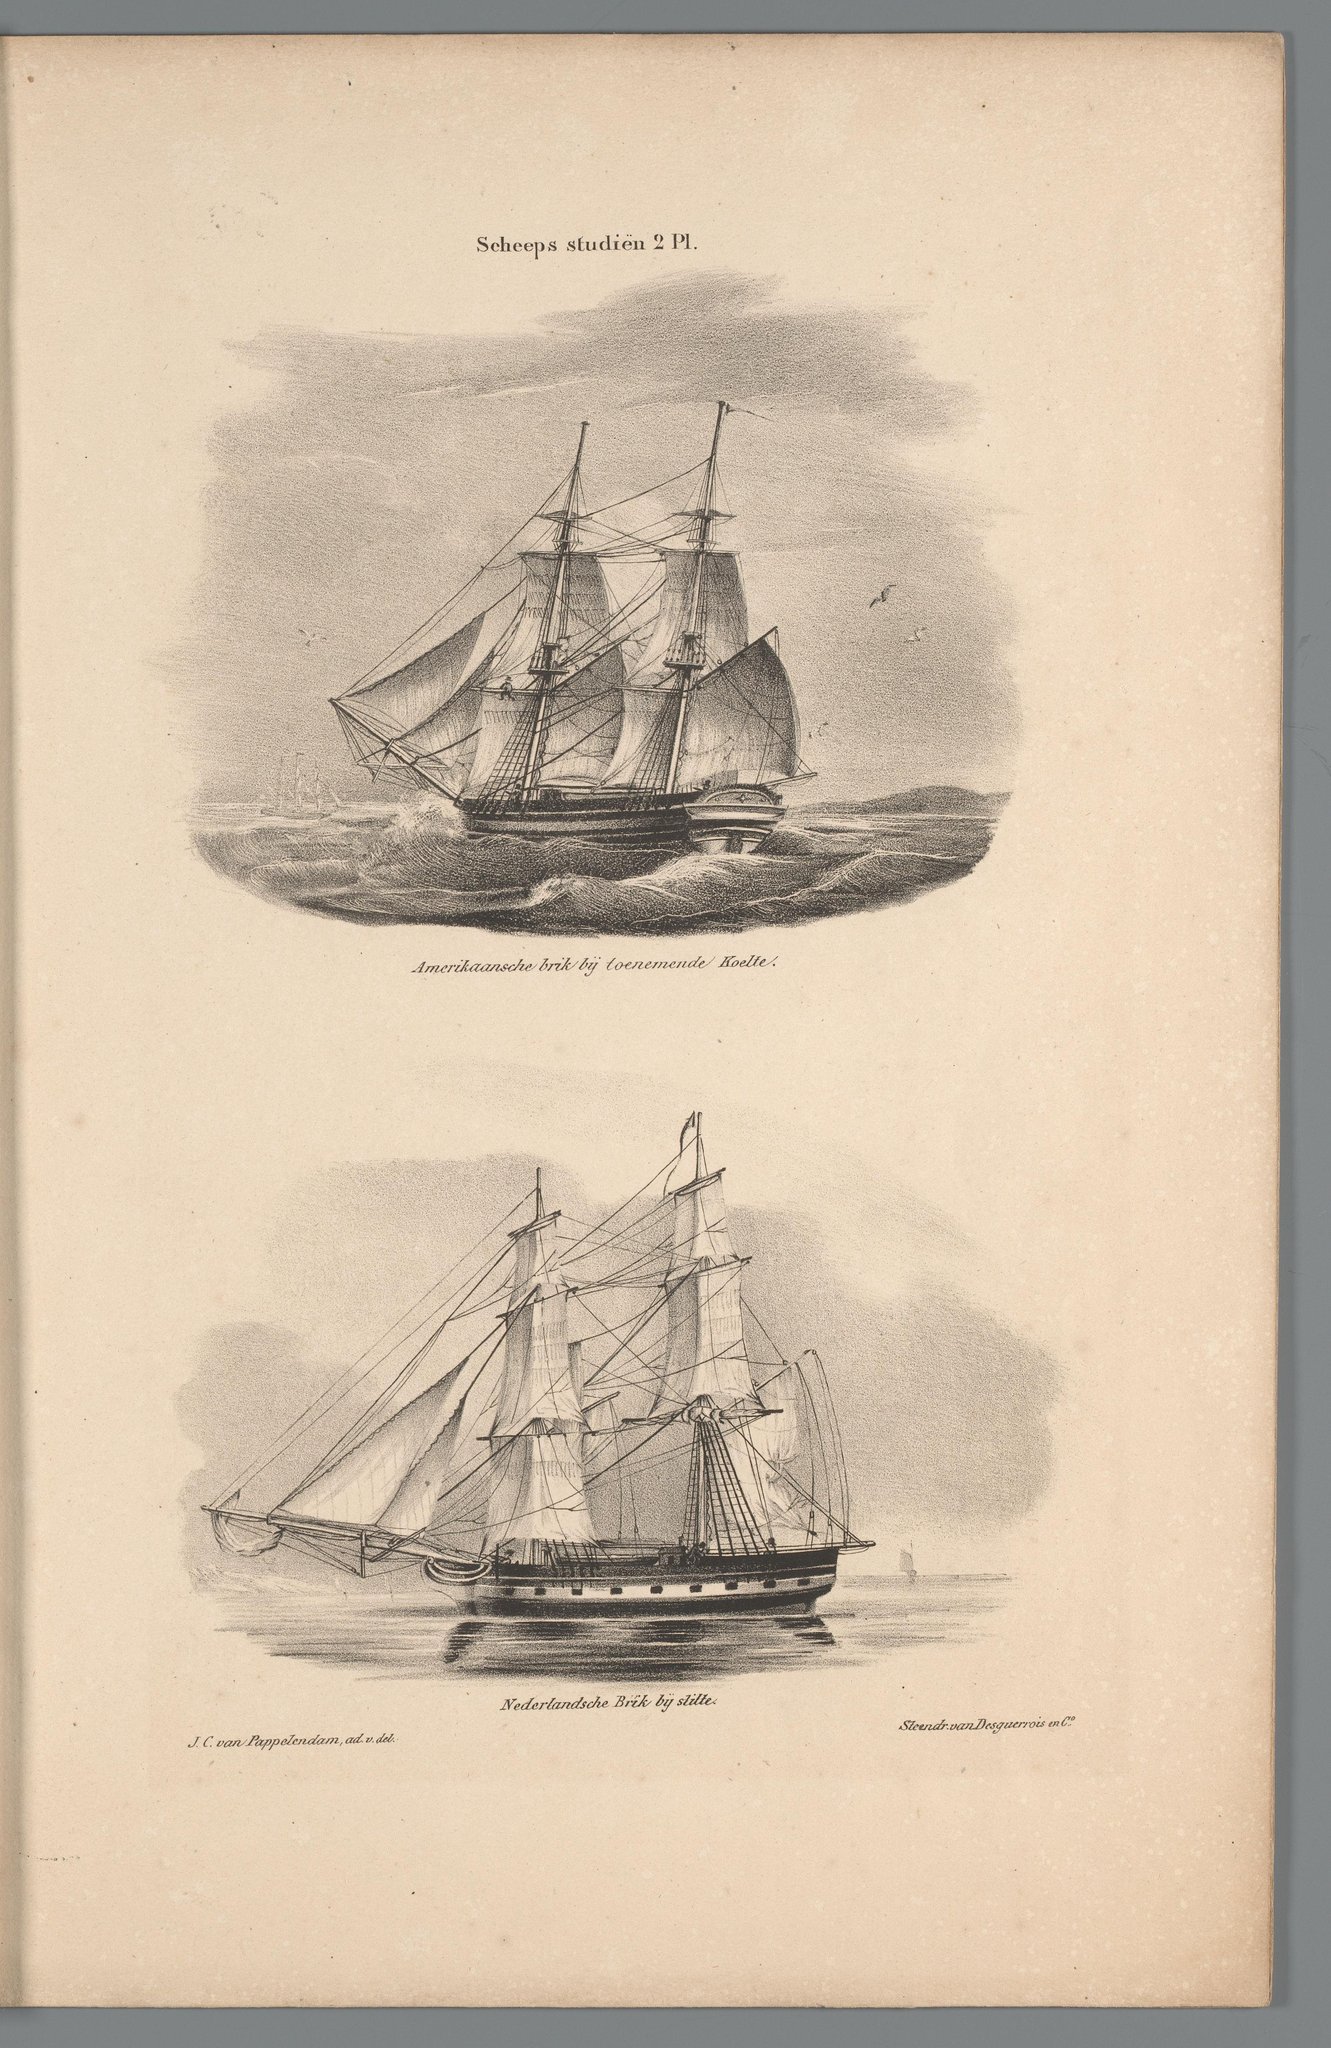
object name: print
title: Twee schepen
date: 1827-1884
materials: paper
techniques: lithograph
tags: ships (in general)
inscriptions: collector's mark: Lugt 2228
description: Maakt deel uit van een prentalbum met een serie van vier lithografieën van schepen.